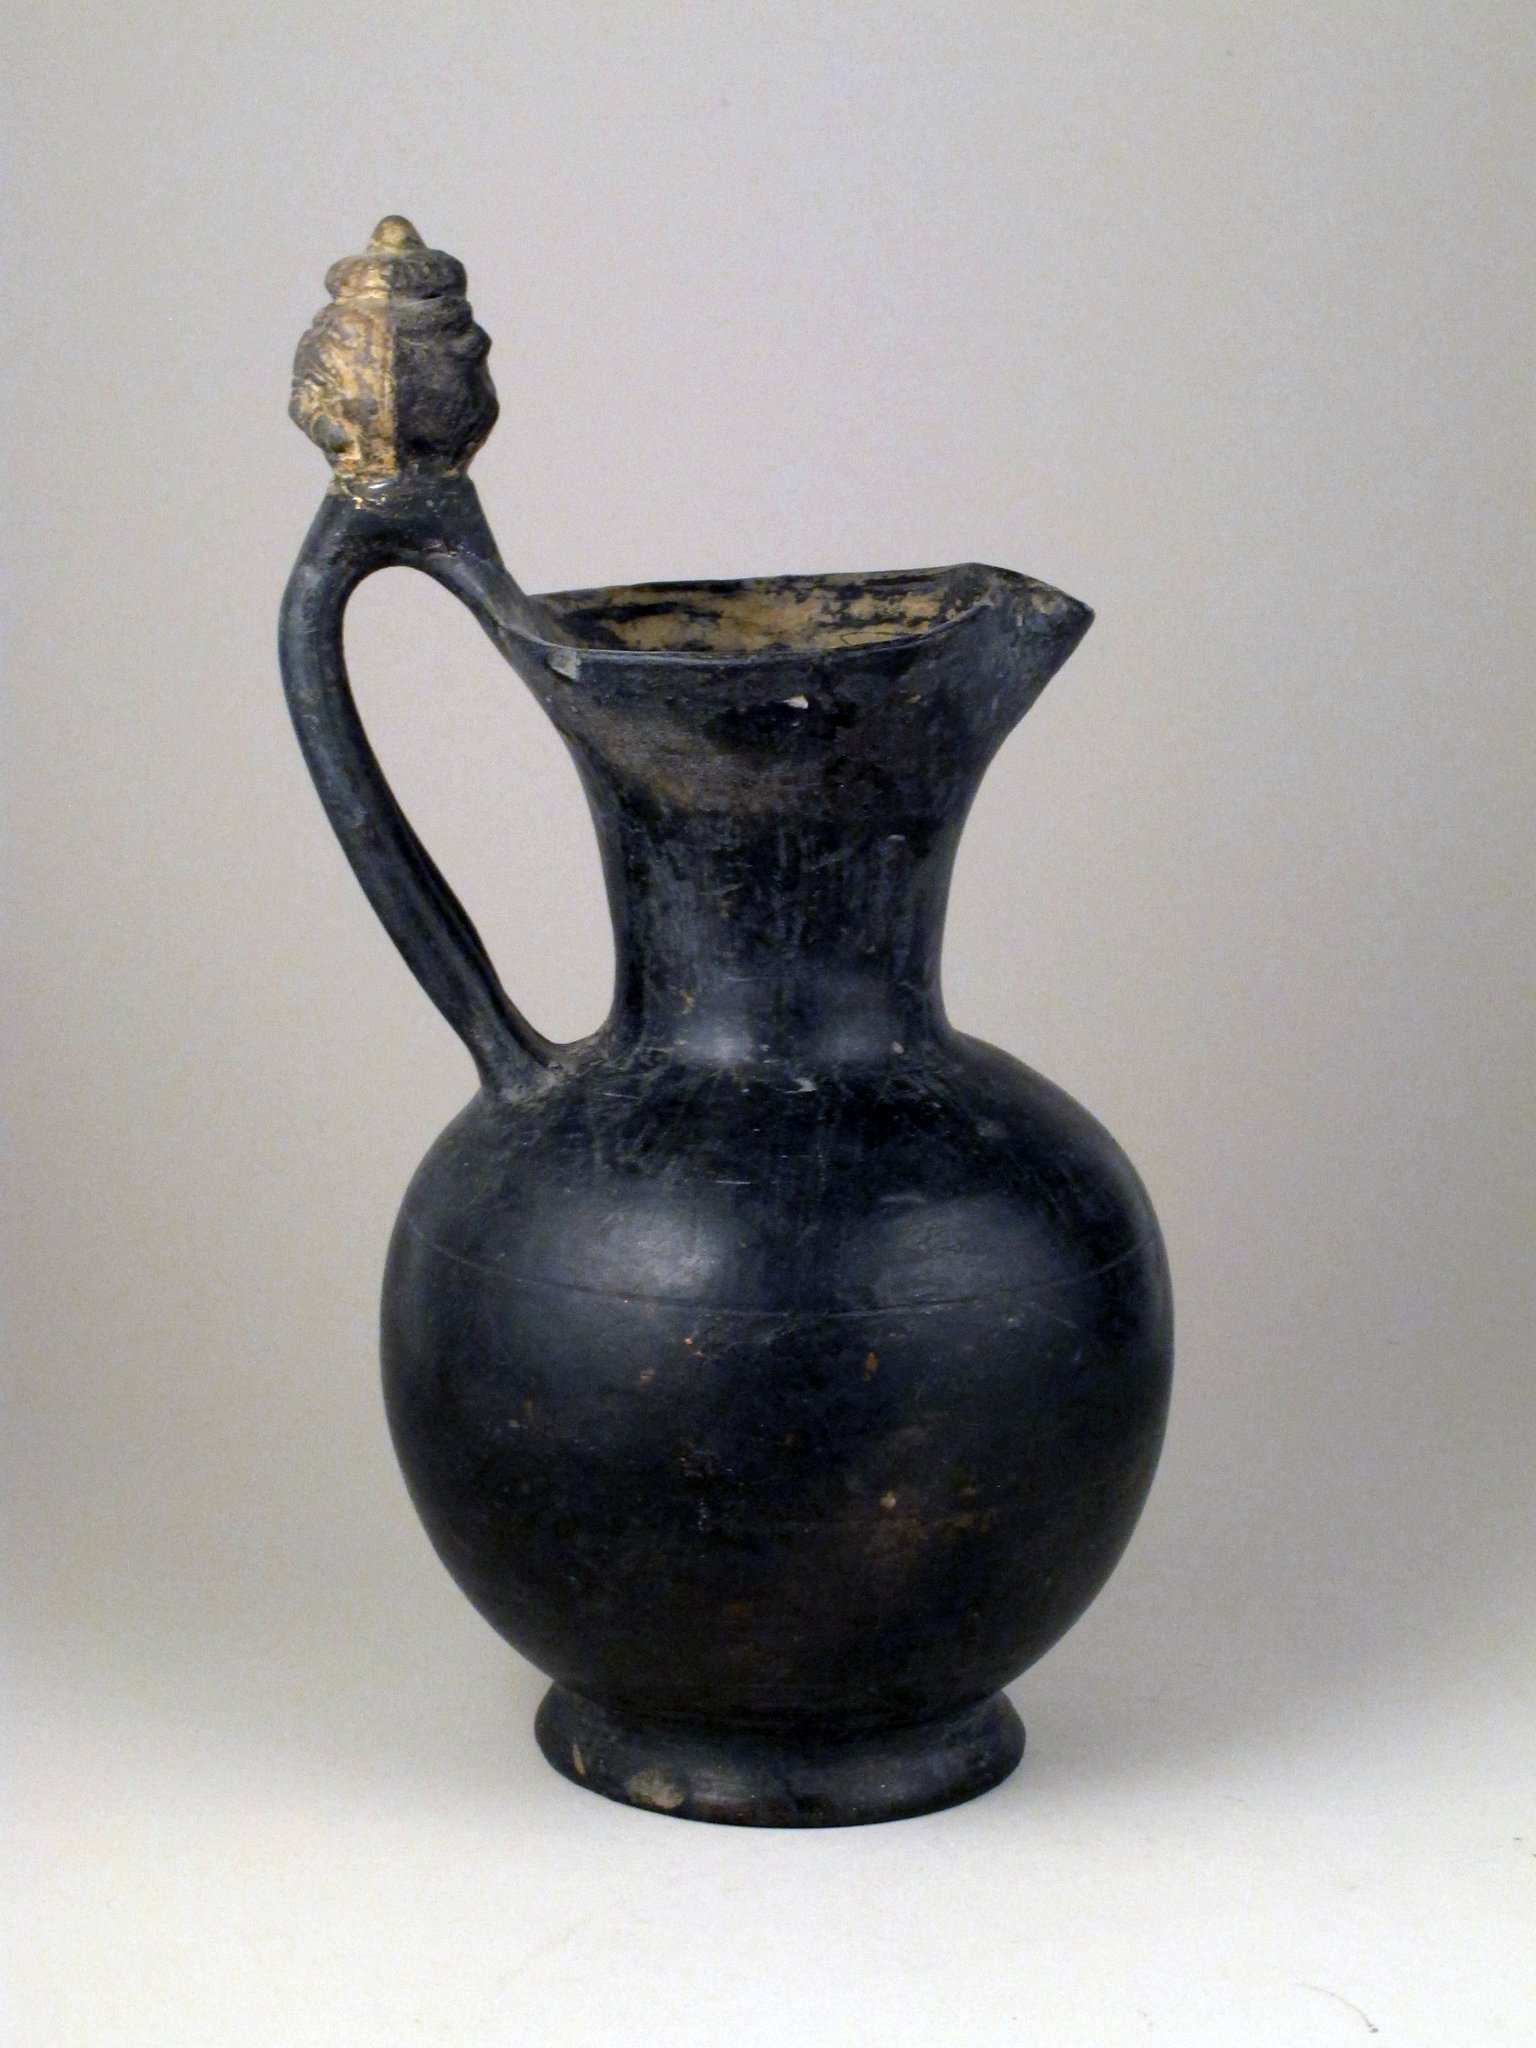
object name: oinochoe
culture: etruscan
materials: terracotta